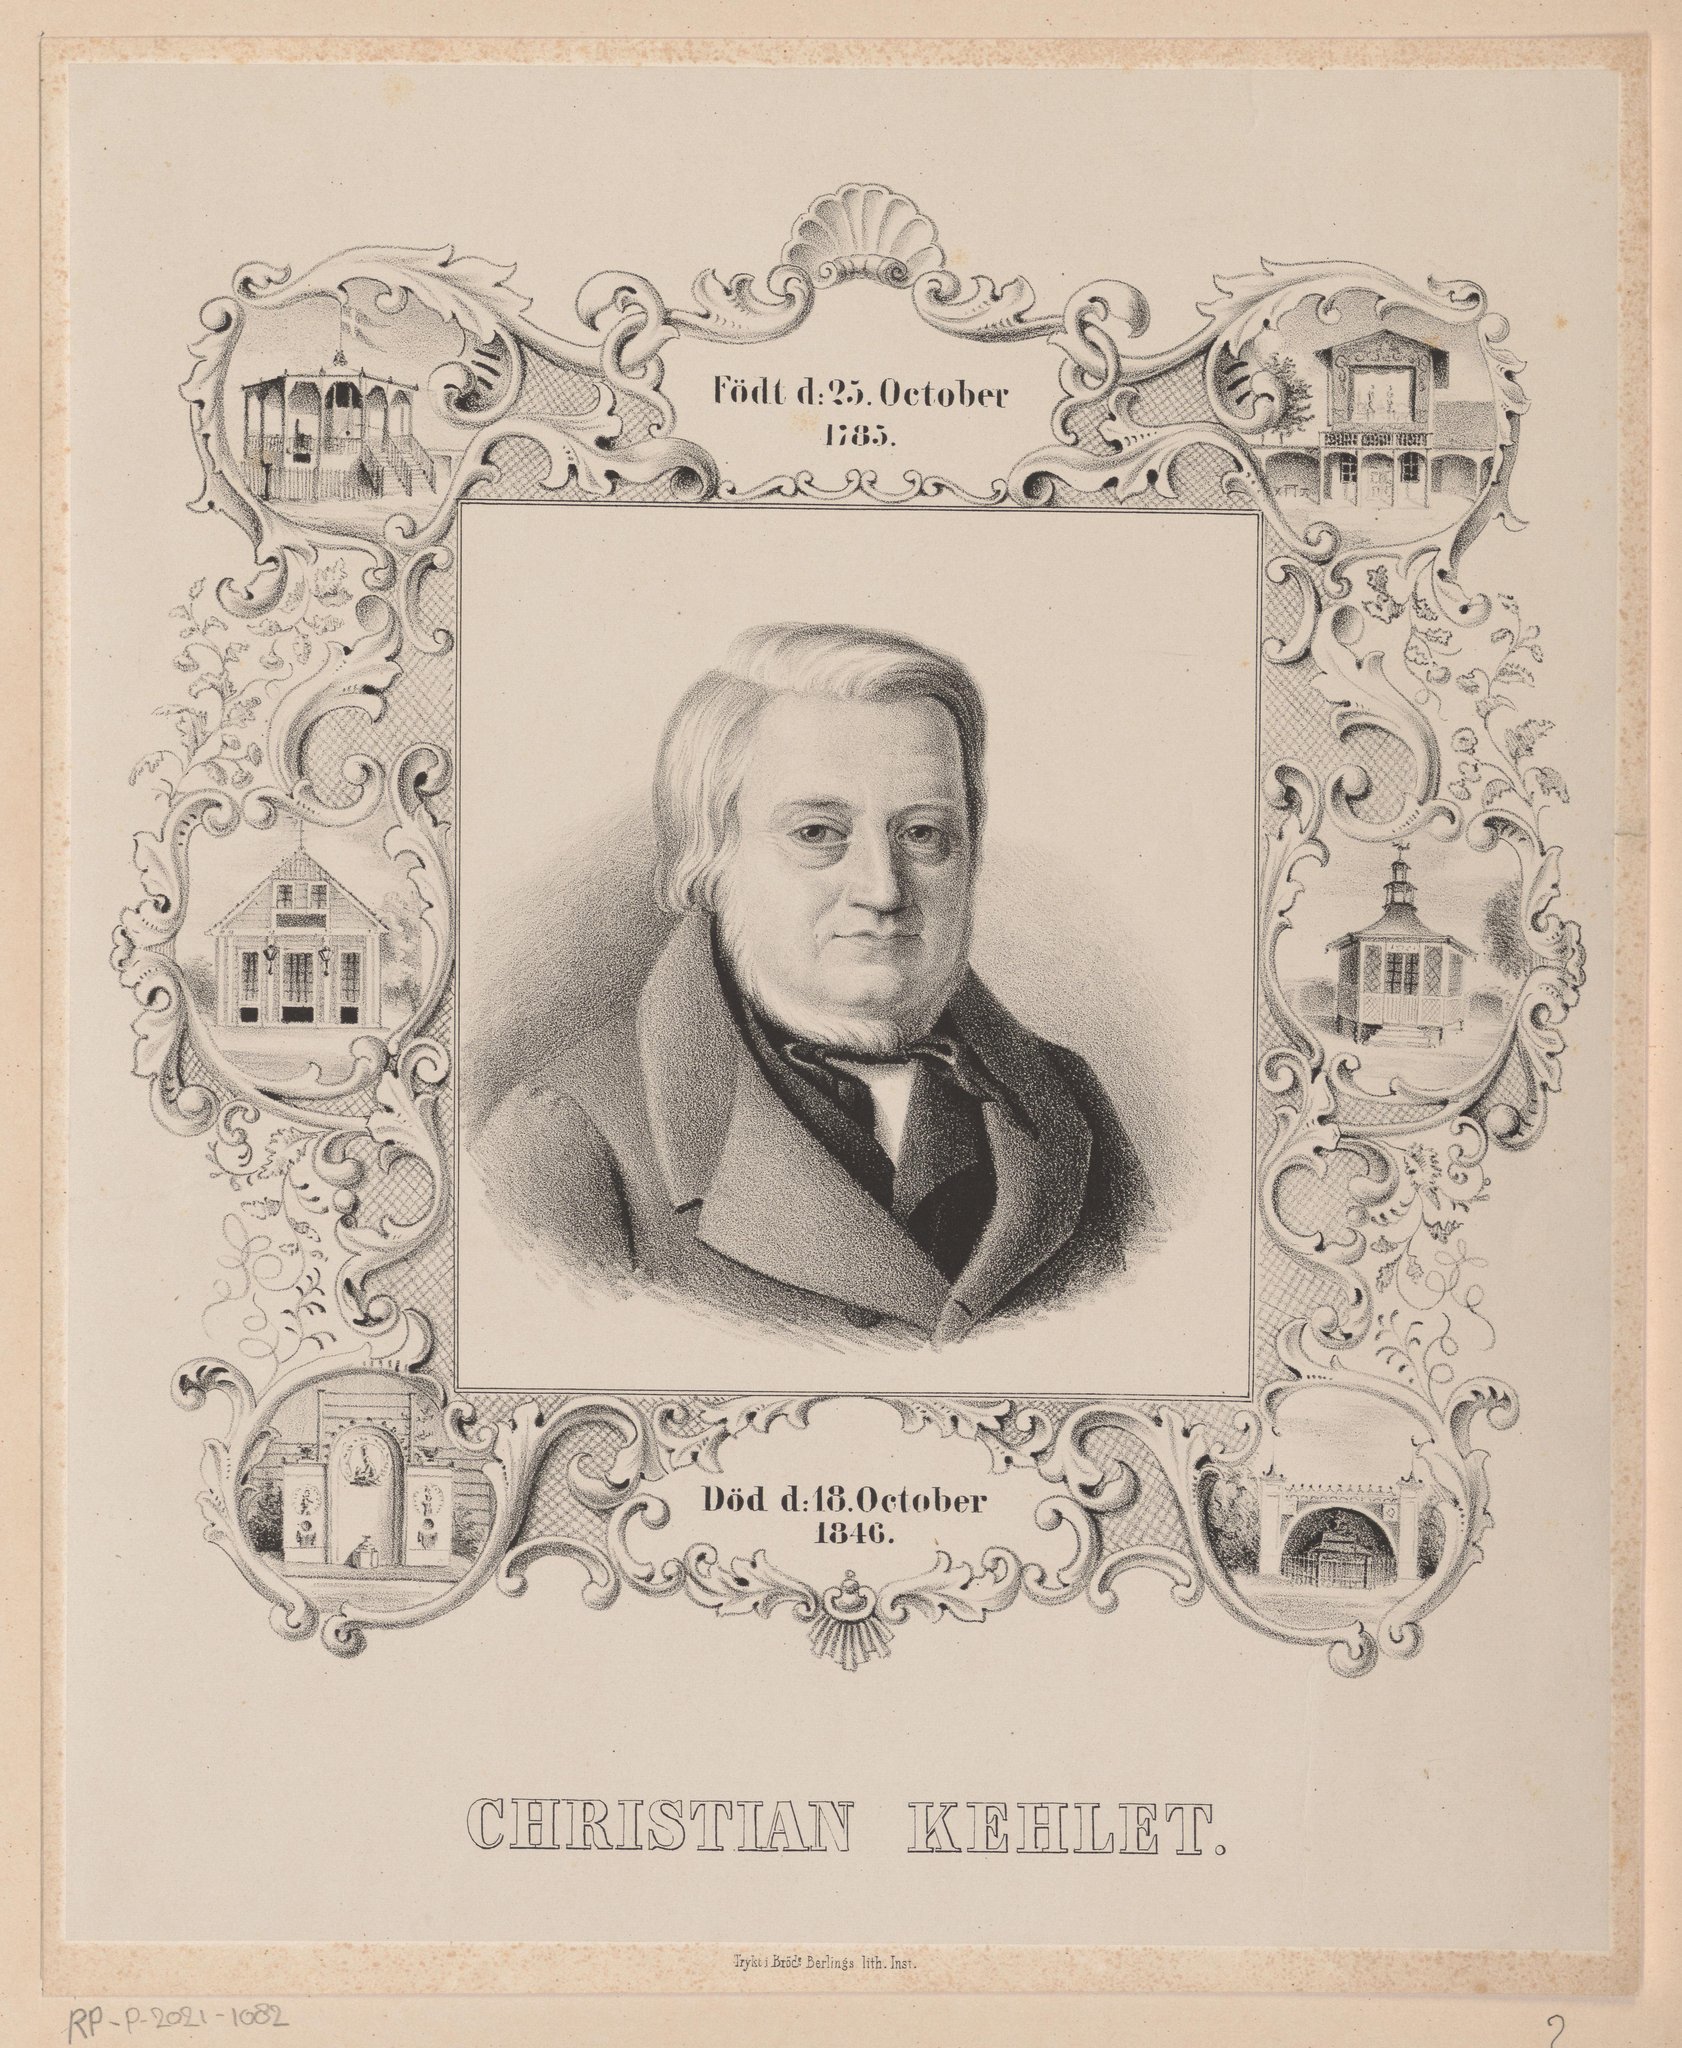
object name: print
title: Portret van Christian Kehlet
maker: Anonymous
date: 1846-1899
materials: paper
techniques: lithograph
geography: copenhagen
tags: manufacturer, historical persons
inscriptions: collector's mark: Lugt 2228